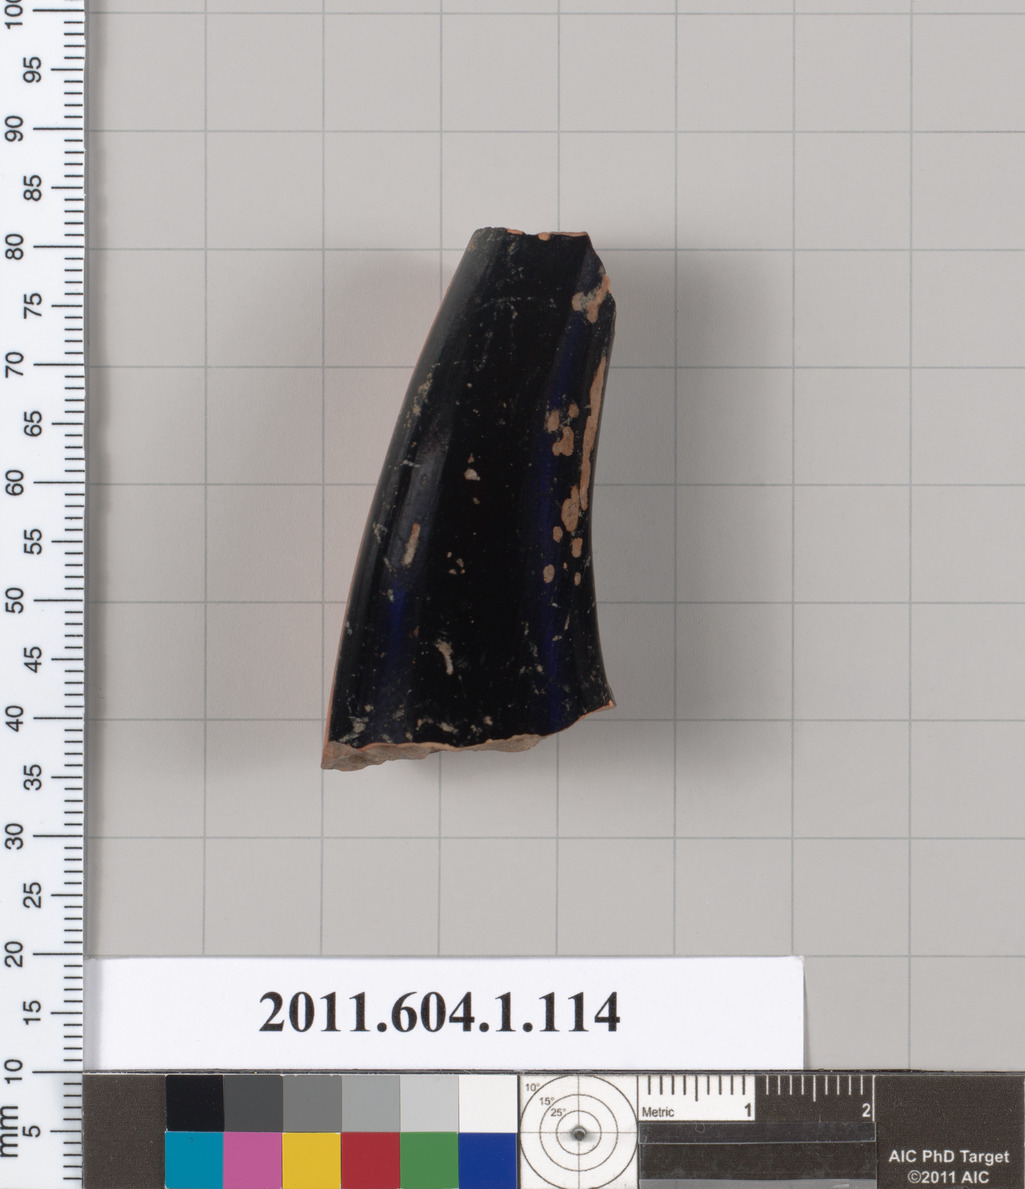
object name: kylix fragment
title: Terracotta fragment of a kylix (drinking cup)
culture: greek, attic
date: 470-450 BCE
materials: terracotta